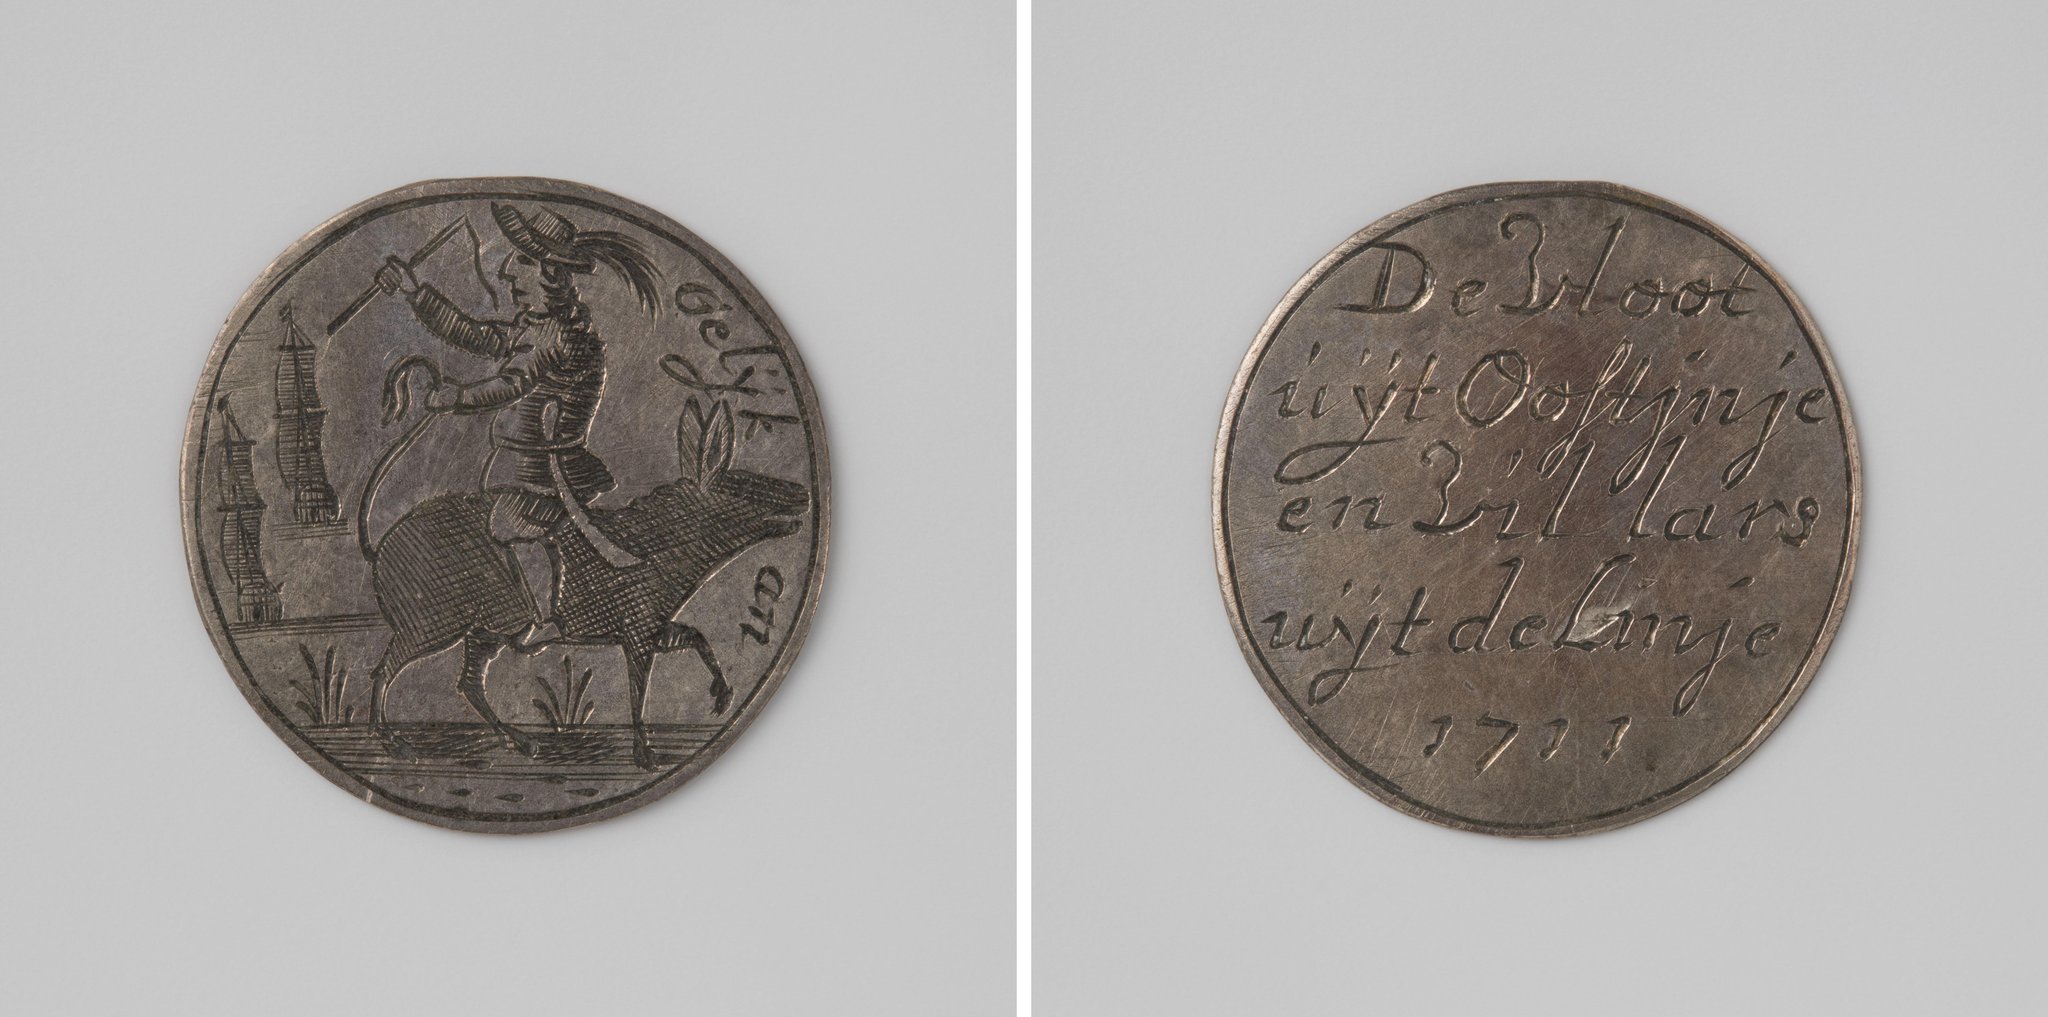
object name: satirical medal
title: Aankomst van de Oost-Indische vloot en de terugtocht van maarschalk de Villars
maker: Anonymous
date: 1711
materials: silver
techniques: engraving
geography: netherlands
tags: verenigde oostindische compagnie, moulins (ille-et-vilaine), turijn, maarschalk, claude louis hector hertog van villars, spaanse successieoorlog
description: Zilveren penning. Voorzijde: man met muts en in rechterhand zweep zit achterstevoren op rund, waarvan hij met andere hand staart vasthoudt; op achtergrond schepen. Keerzijde: opschrift